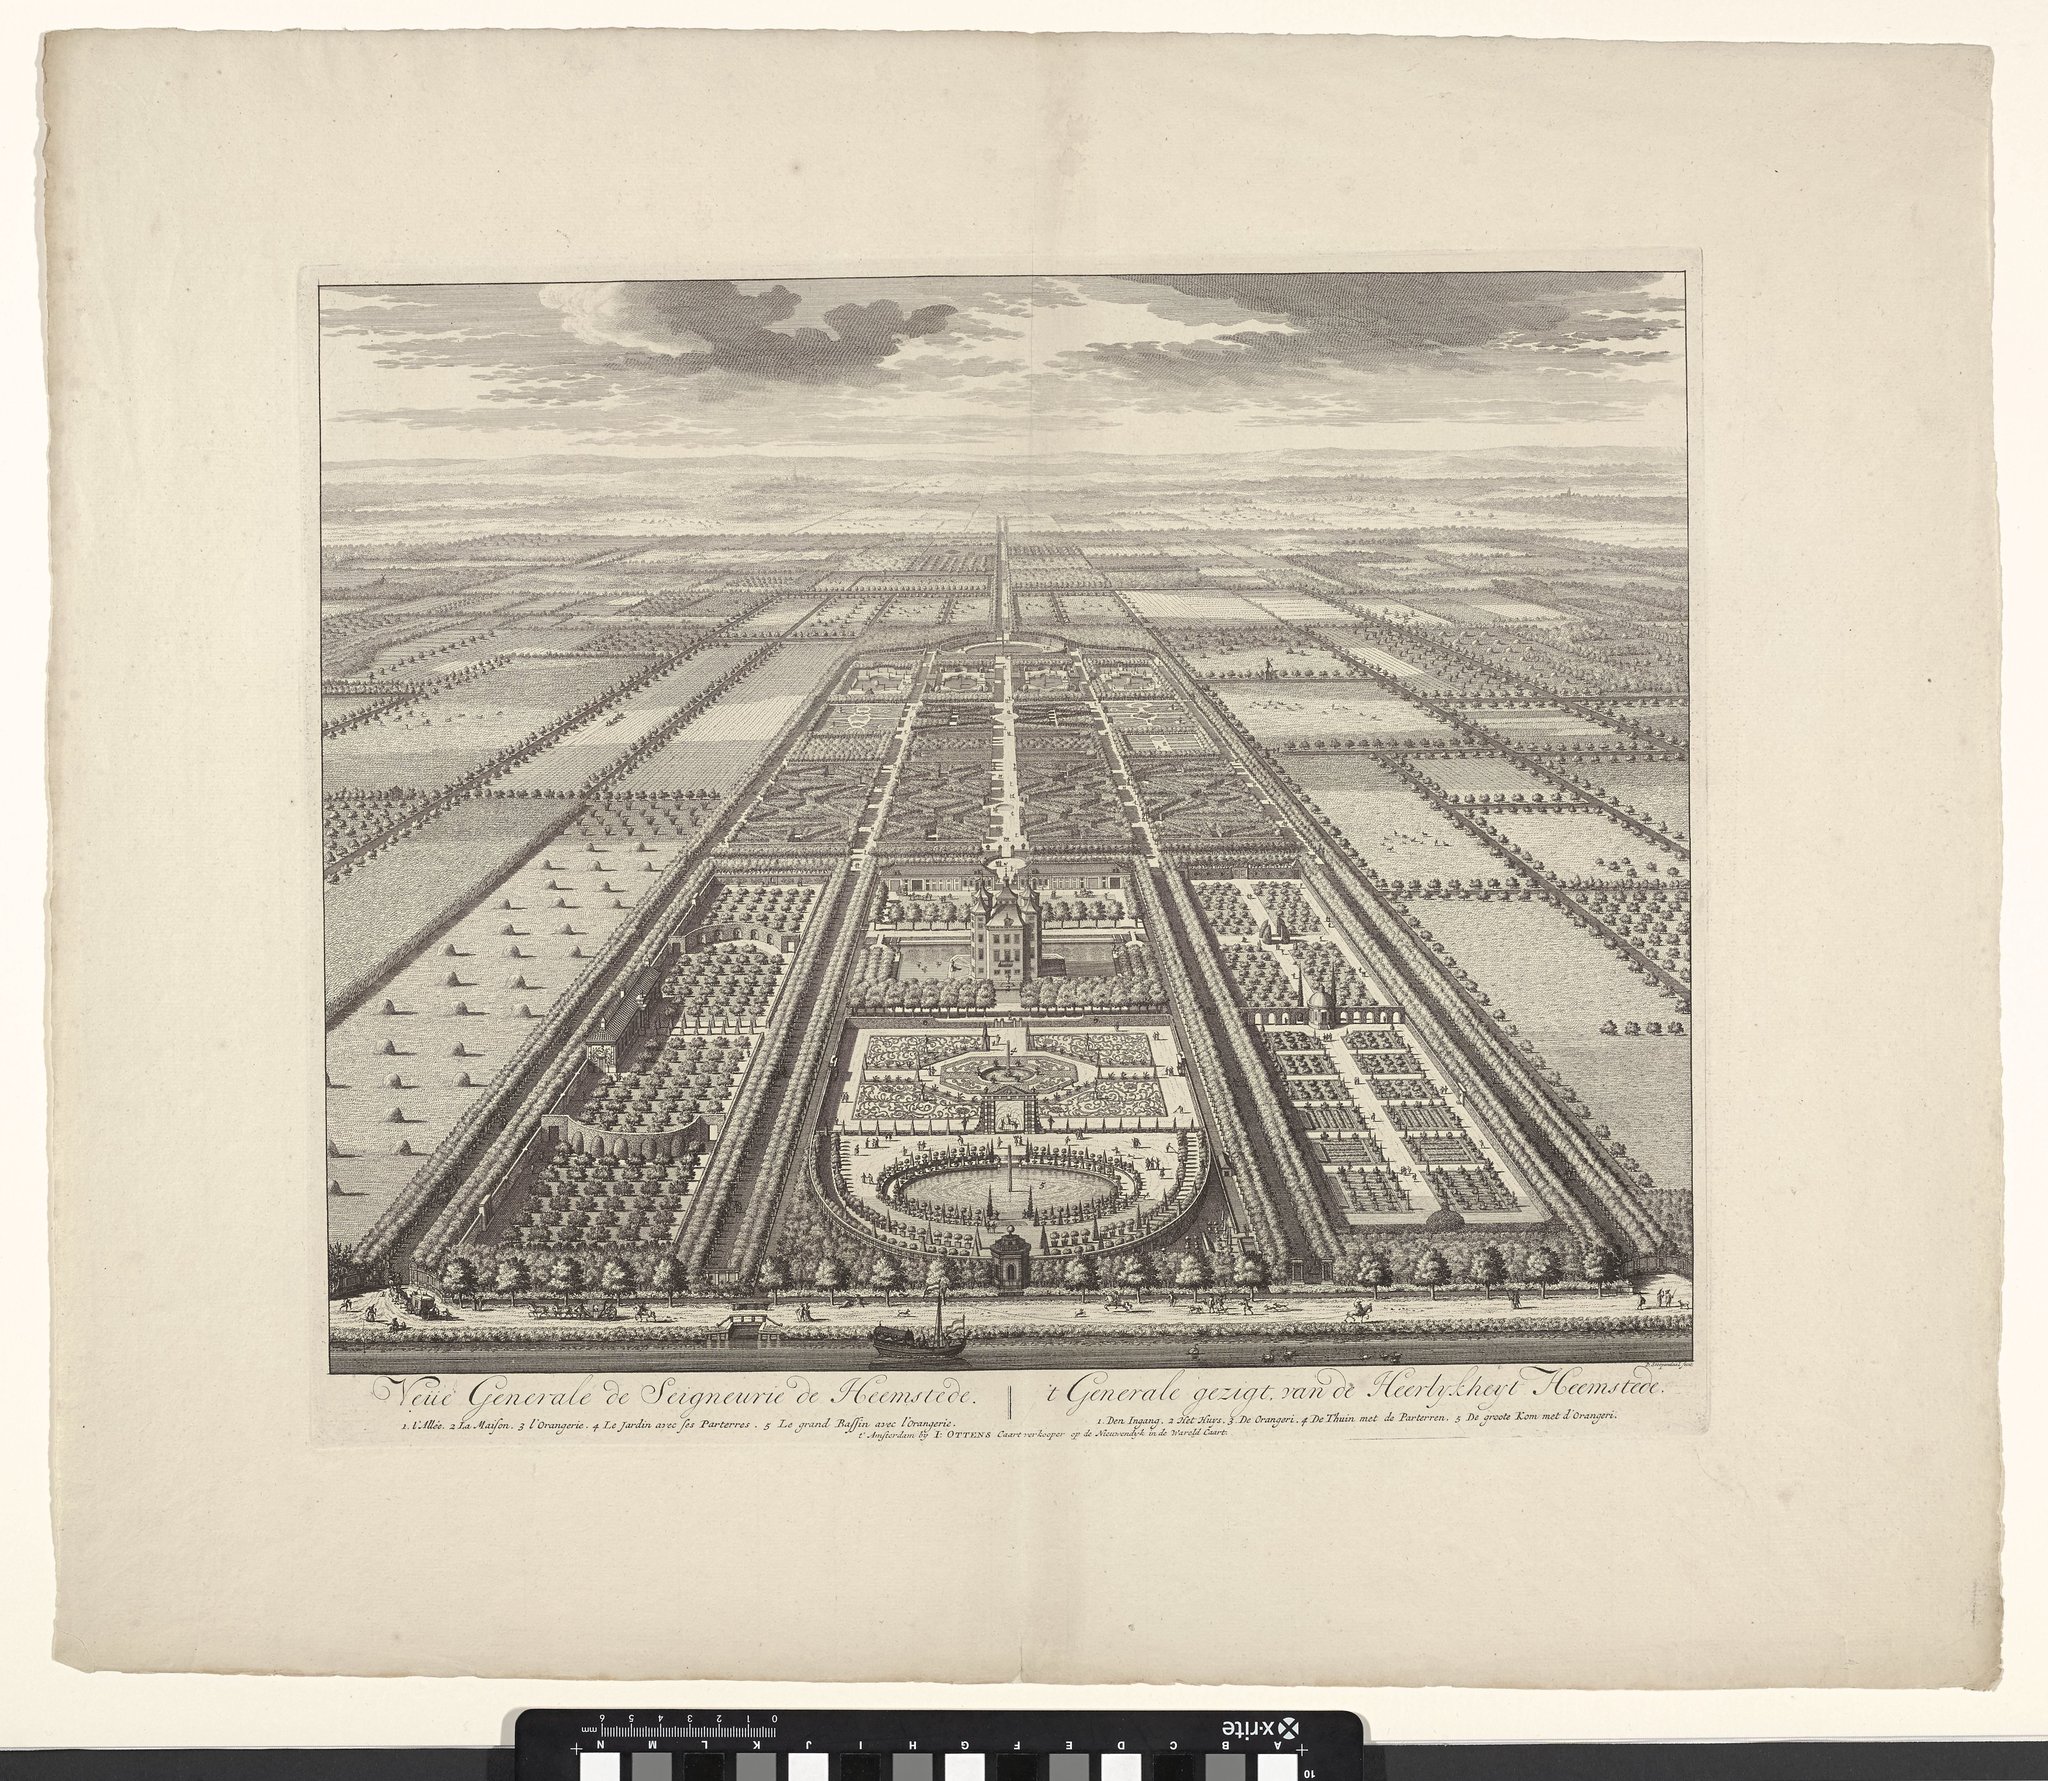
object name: print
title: "'t Generale gezigt, van de Heerlijkheyt Heemstede." Rechts onderaan: D. Stoopendaal fecit. Geheel onderaan het adres: 't Amsterdam bij I. Ottens Caartverkooper op de Nieuwendijk in de Wareld Caart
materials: paper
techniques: etching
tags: bird's eye view ~ representation of building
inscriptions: title: ‘Veue Generale de Seigneurie de Heemstede.’, signature: ‘D. Stoopendaal fecit’, caption: ‘1. L' Allée.......5. De groote Kom met d' Orangerie’, title: ‘' t Generale gezicht van de Heerlykheyt Heemstede ’, address: ‘t' Amsterdam bij I: Ottens Caartverkooper op de Nieuwendyk in de Wereld Caart.’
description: Het landgoed Heemstede in vogelvlucht. In het midden het kasteel, daaromheen de parken en landerijen. Met nummers aangeduid. Uitleg onder de voorstelling. Ruiters en wandelaars klein op de voorgrond.